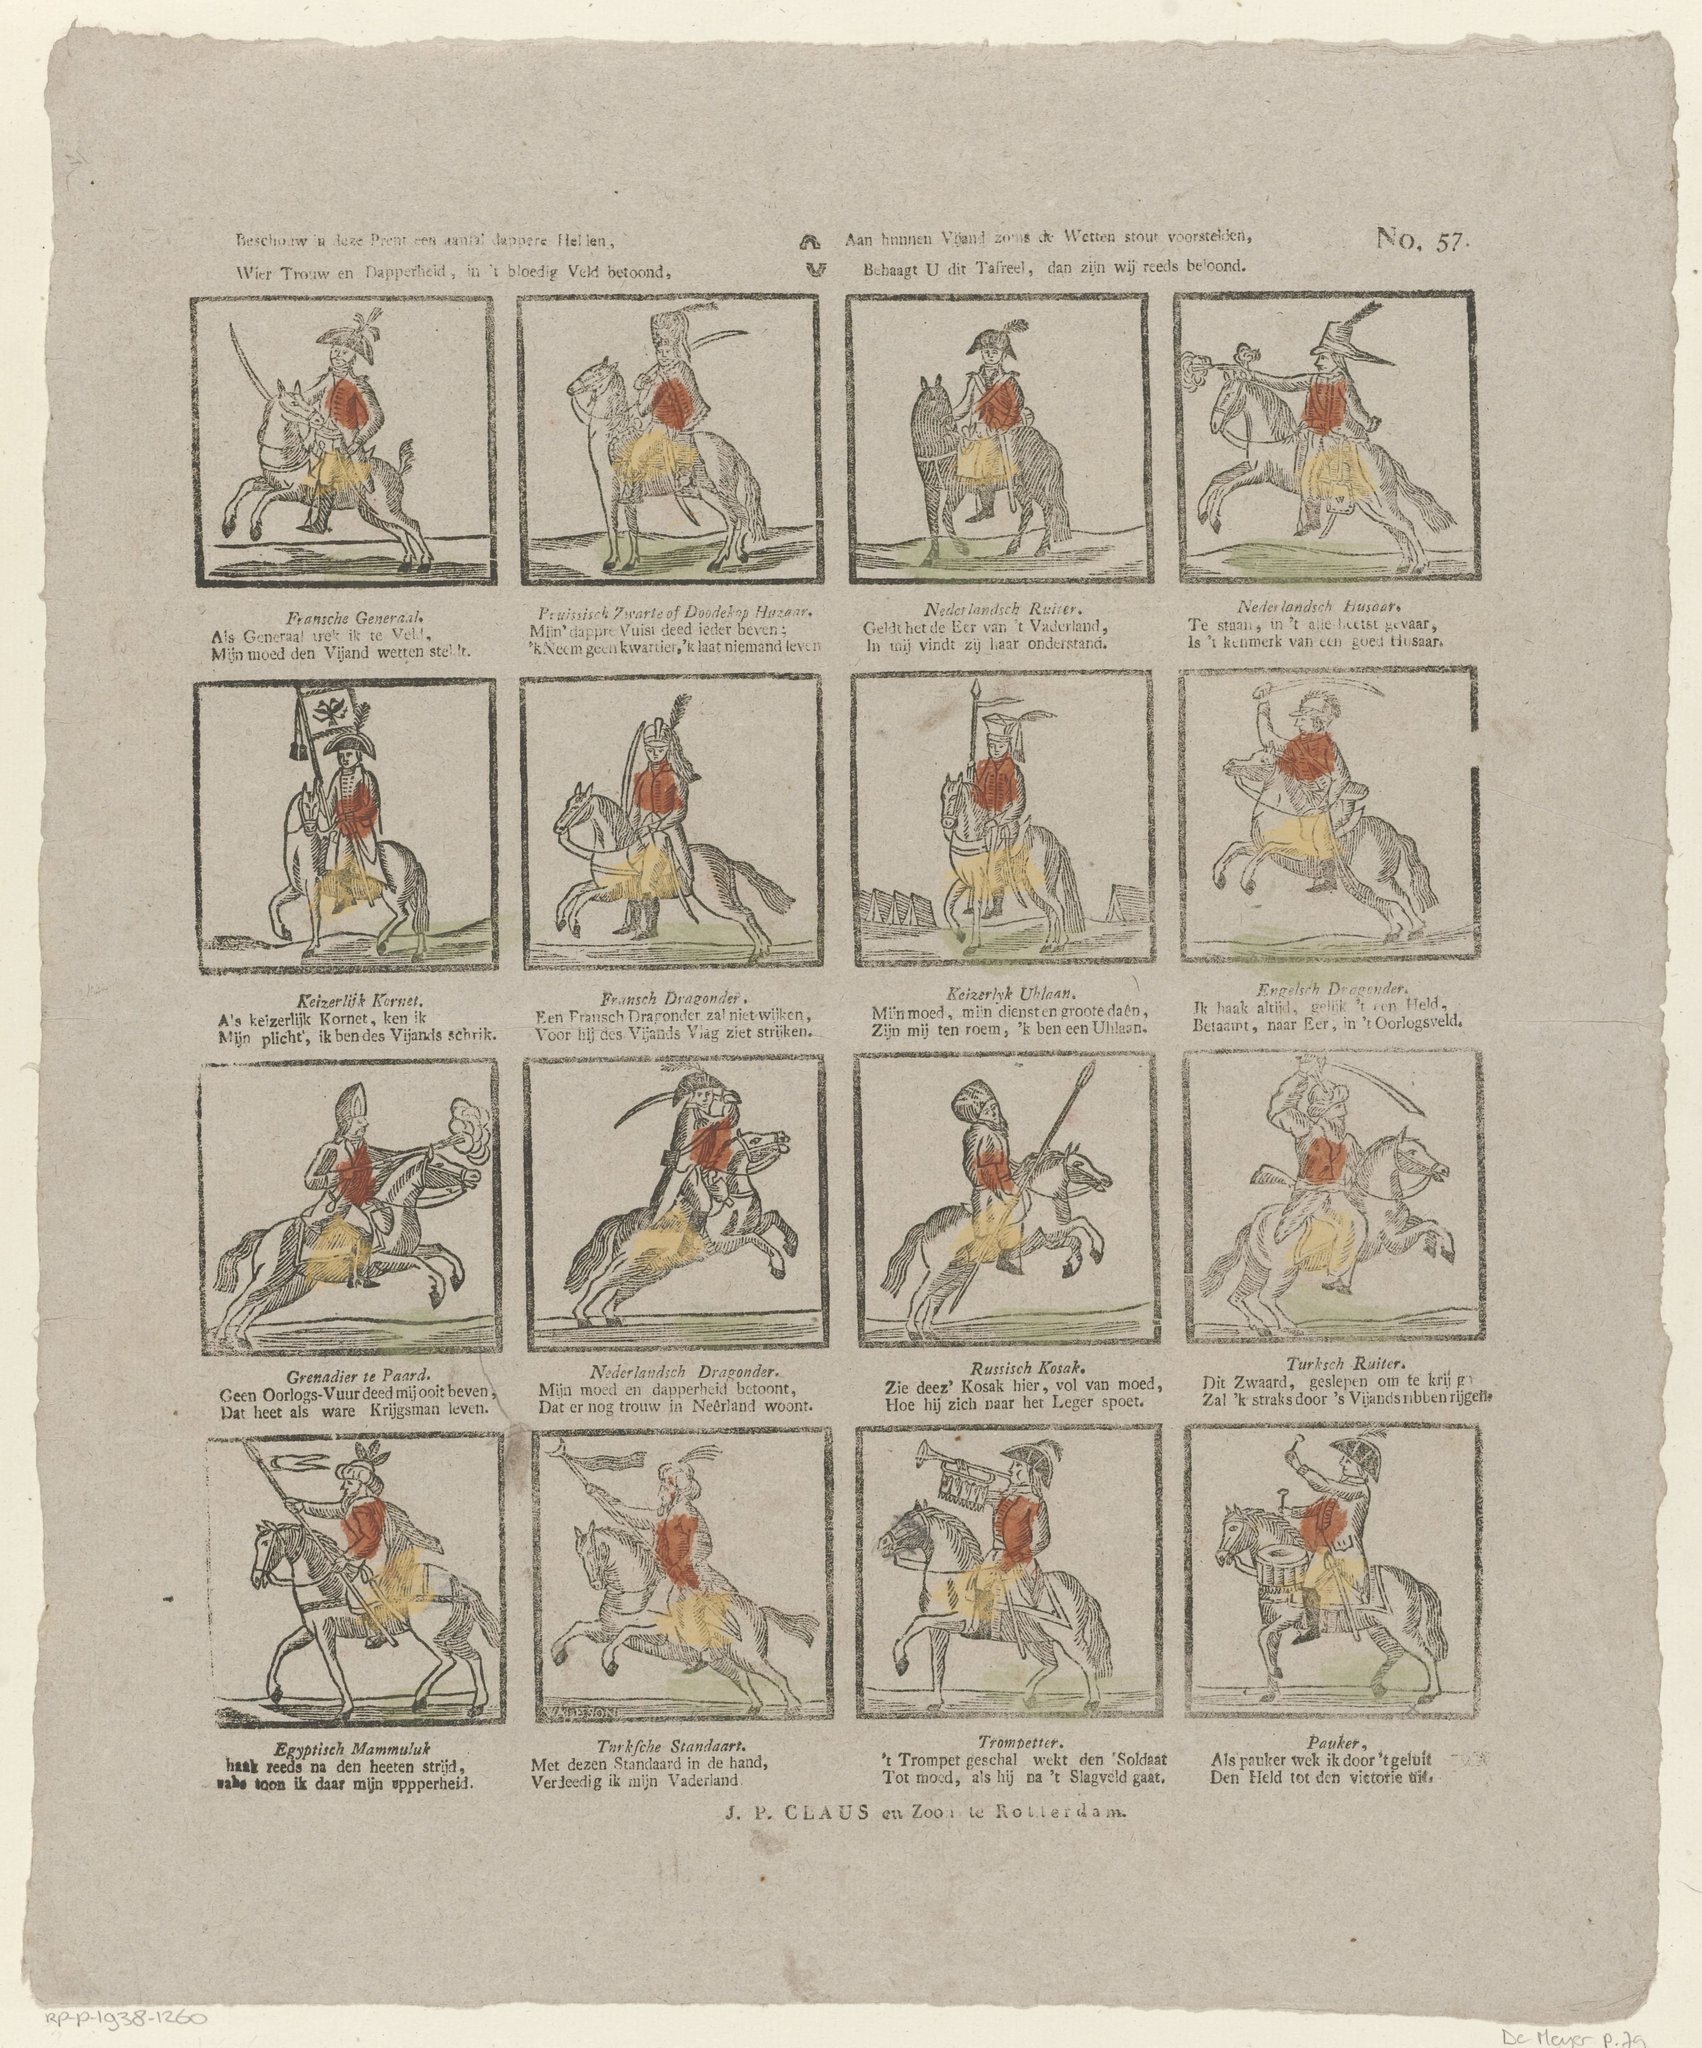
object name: print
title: Beschouw in deze prent een aantal dappere helden, / Wier trouw en dapperheid, in 't bloedig veld betoond, / Aan hunnen vijand soms de wetten stout voorstelde, / Behaagt u dit tafereel, dan zyn wy reeds beloond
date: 1862-1905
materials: paper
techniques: colour, letterpress printing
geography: breda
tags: riding a horse, ass, or mule; rider, horseman, weapons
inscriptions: collector's mark: Lugt 2760, collector's mark: Lugt 2228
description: Blad met 16 voorstellingen van militairen te paard. Onder elke afbeelding een naam en tweeregelig vers. Genummerd rechtsboven: No. 57.